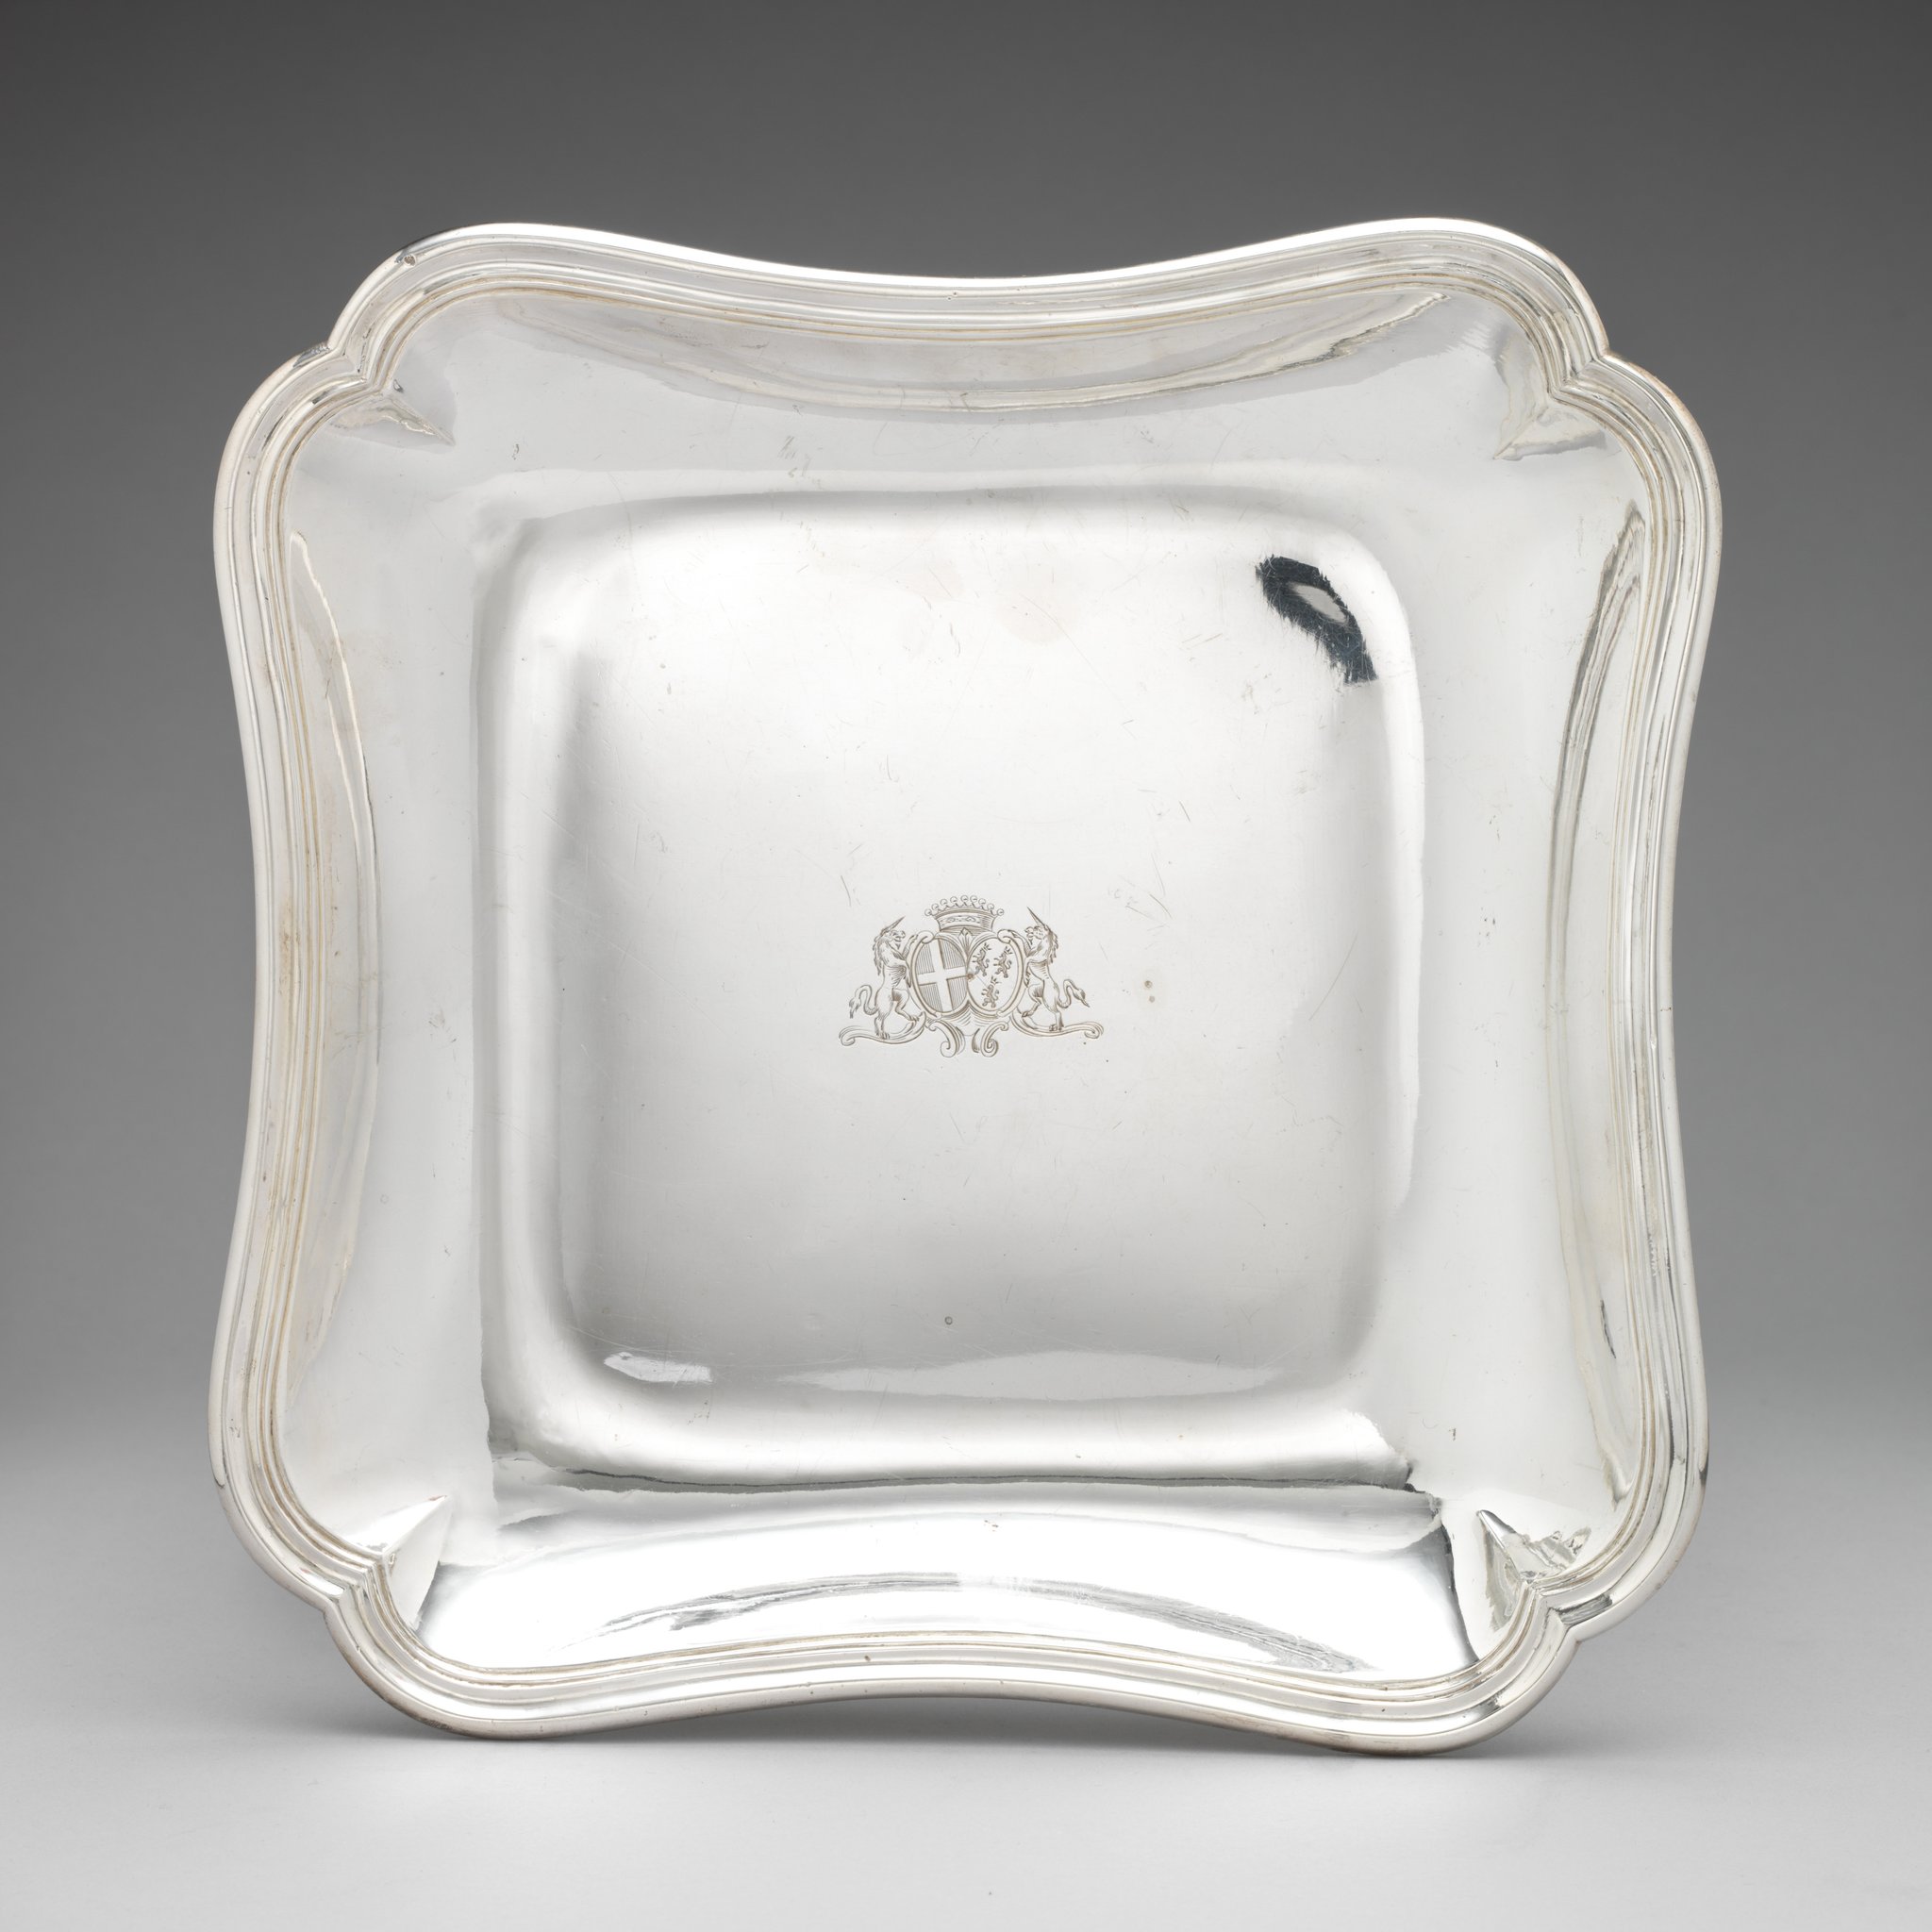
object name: dish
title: Square dish (one of a pair)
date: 1775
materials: silver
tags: coat of arms